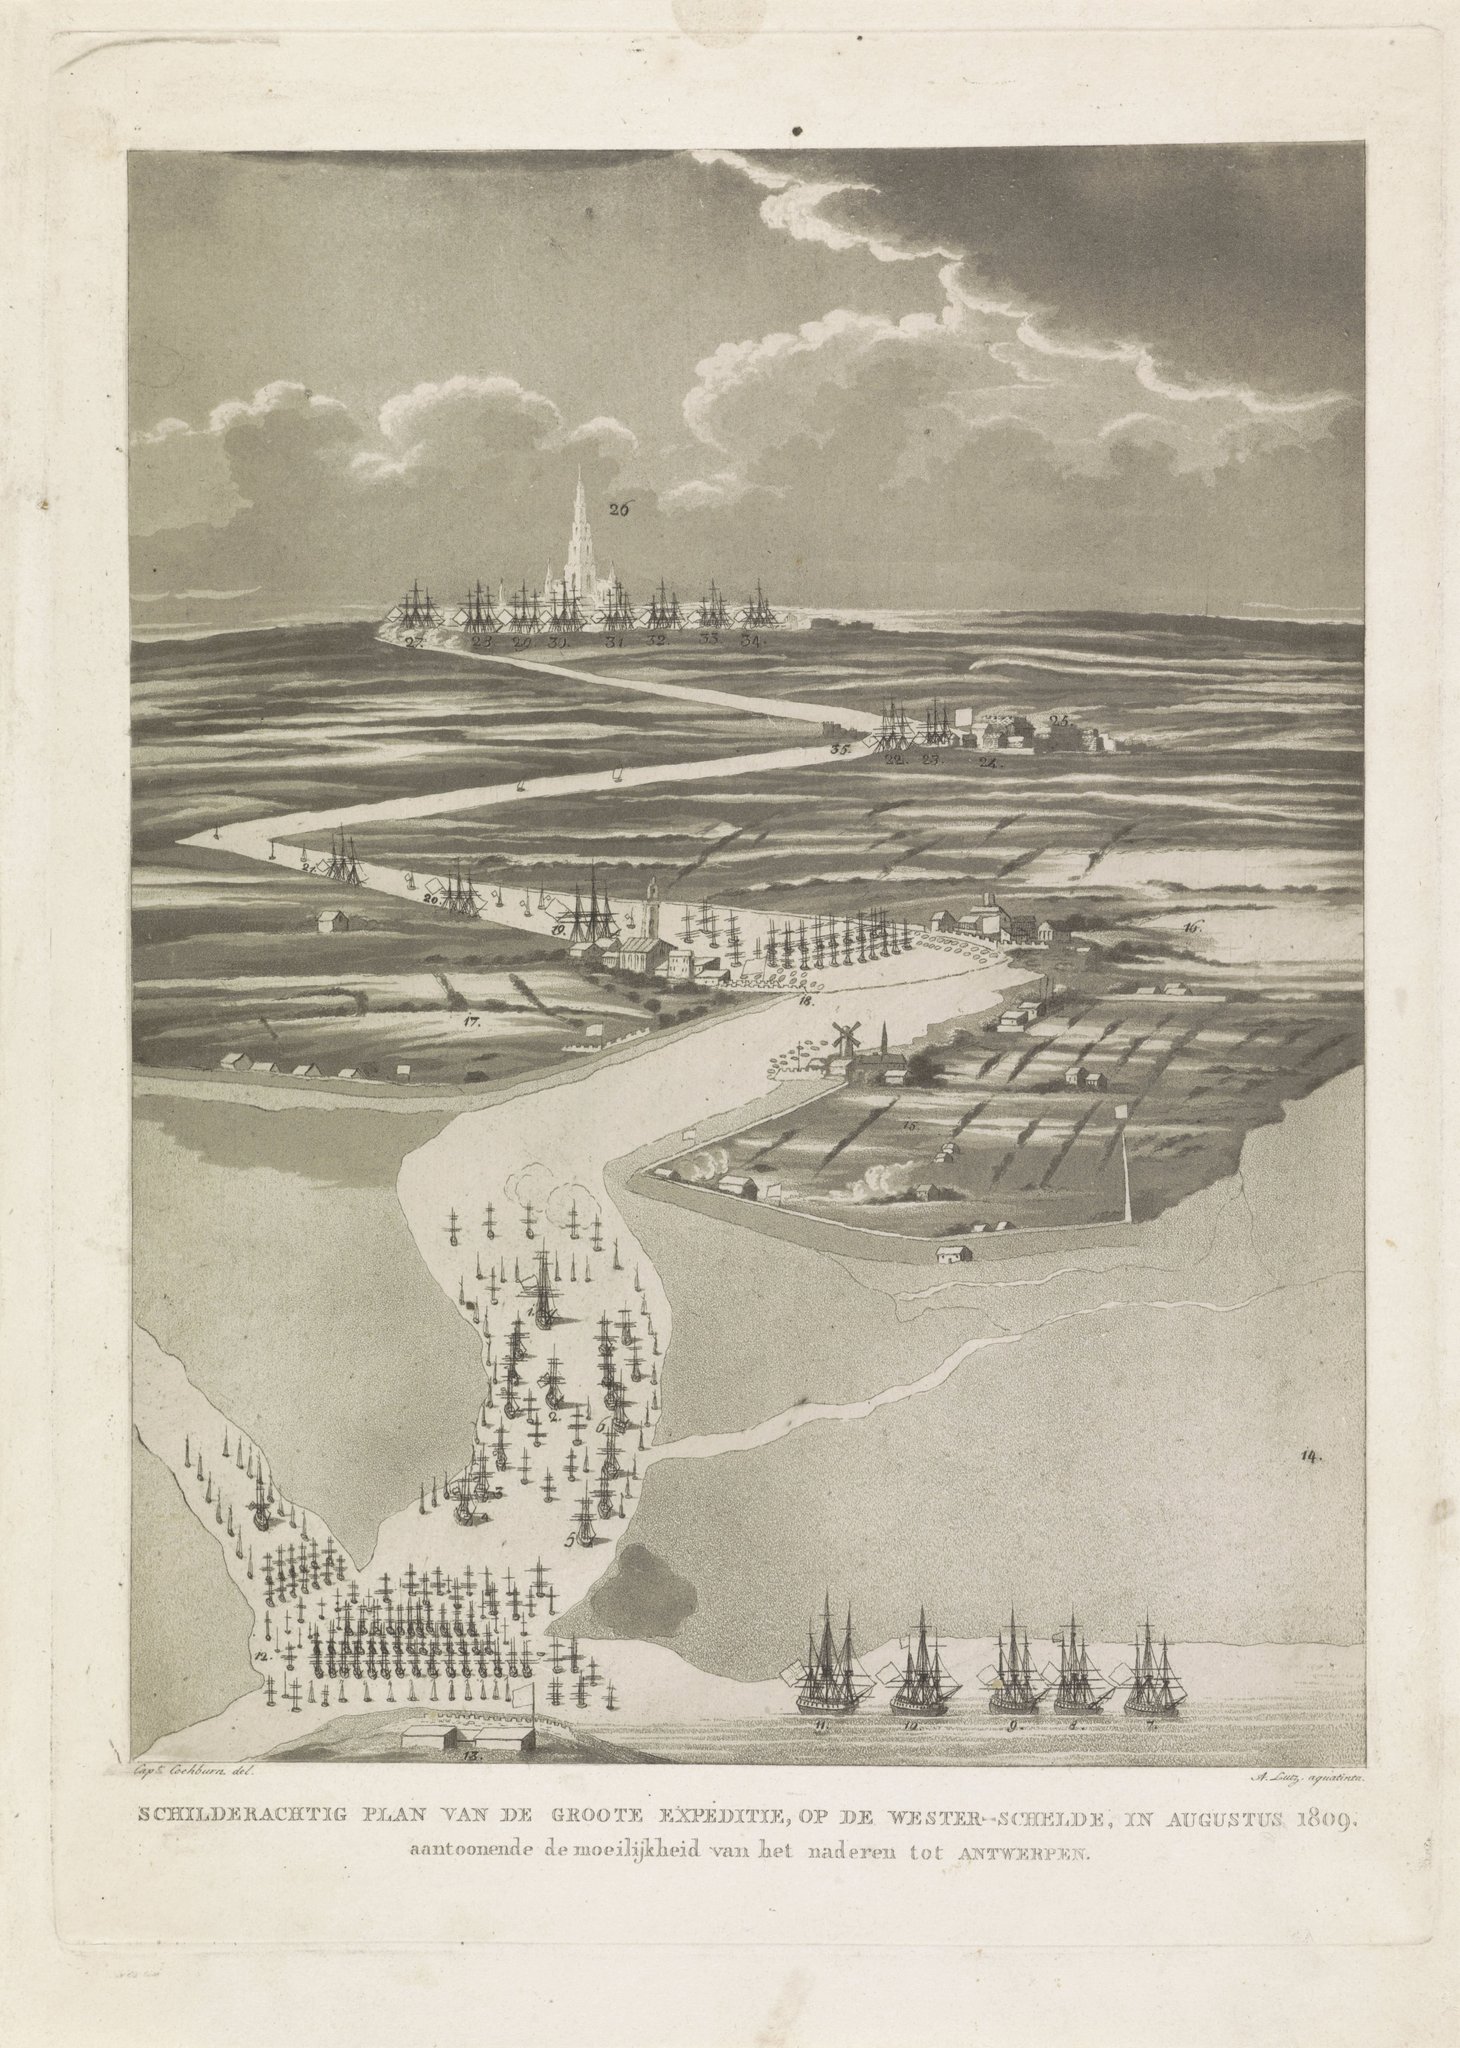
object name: print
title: Schilderachtig plan van de groote Expeditie, op de Wester-schelde, in augustus 1809. aantoonende de moeilijkheid van het naderen tot Antwerpen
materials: paper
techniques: aquatint, etching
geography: england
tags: (military) attack (+ sailing-ships), antwerp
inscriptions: collector's mark: Lugt 2228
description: Landschap met gezicht in vogelvlucht van de loop van de rivier de Schelde naar de stad Antwerpen. Op de voorgrond vaart de Britse vloot in augustus 1809 voorbij Fort Bath de Schelde op richting Antwerpen, halverwege is tussen Fort Lillo en Liefkenshoek een ketting over de rivier gespannen, achter de ketting ligt de Franse vloot. In de verte de stad Antwerpen waarvoor een achttal Franse schepen liggen. Titel en opschriften in het Nederlands. Bij de prent behoort een uitleg.